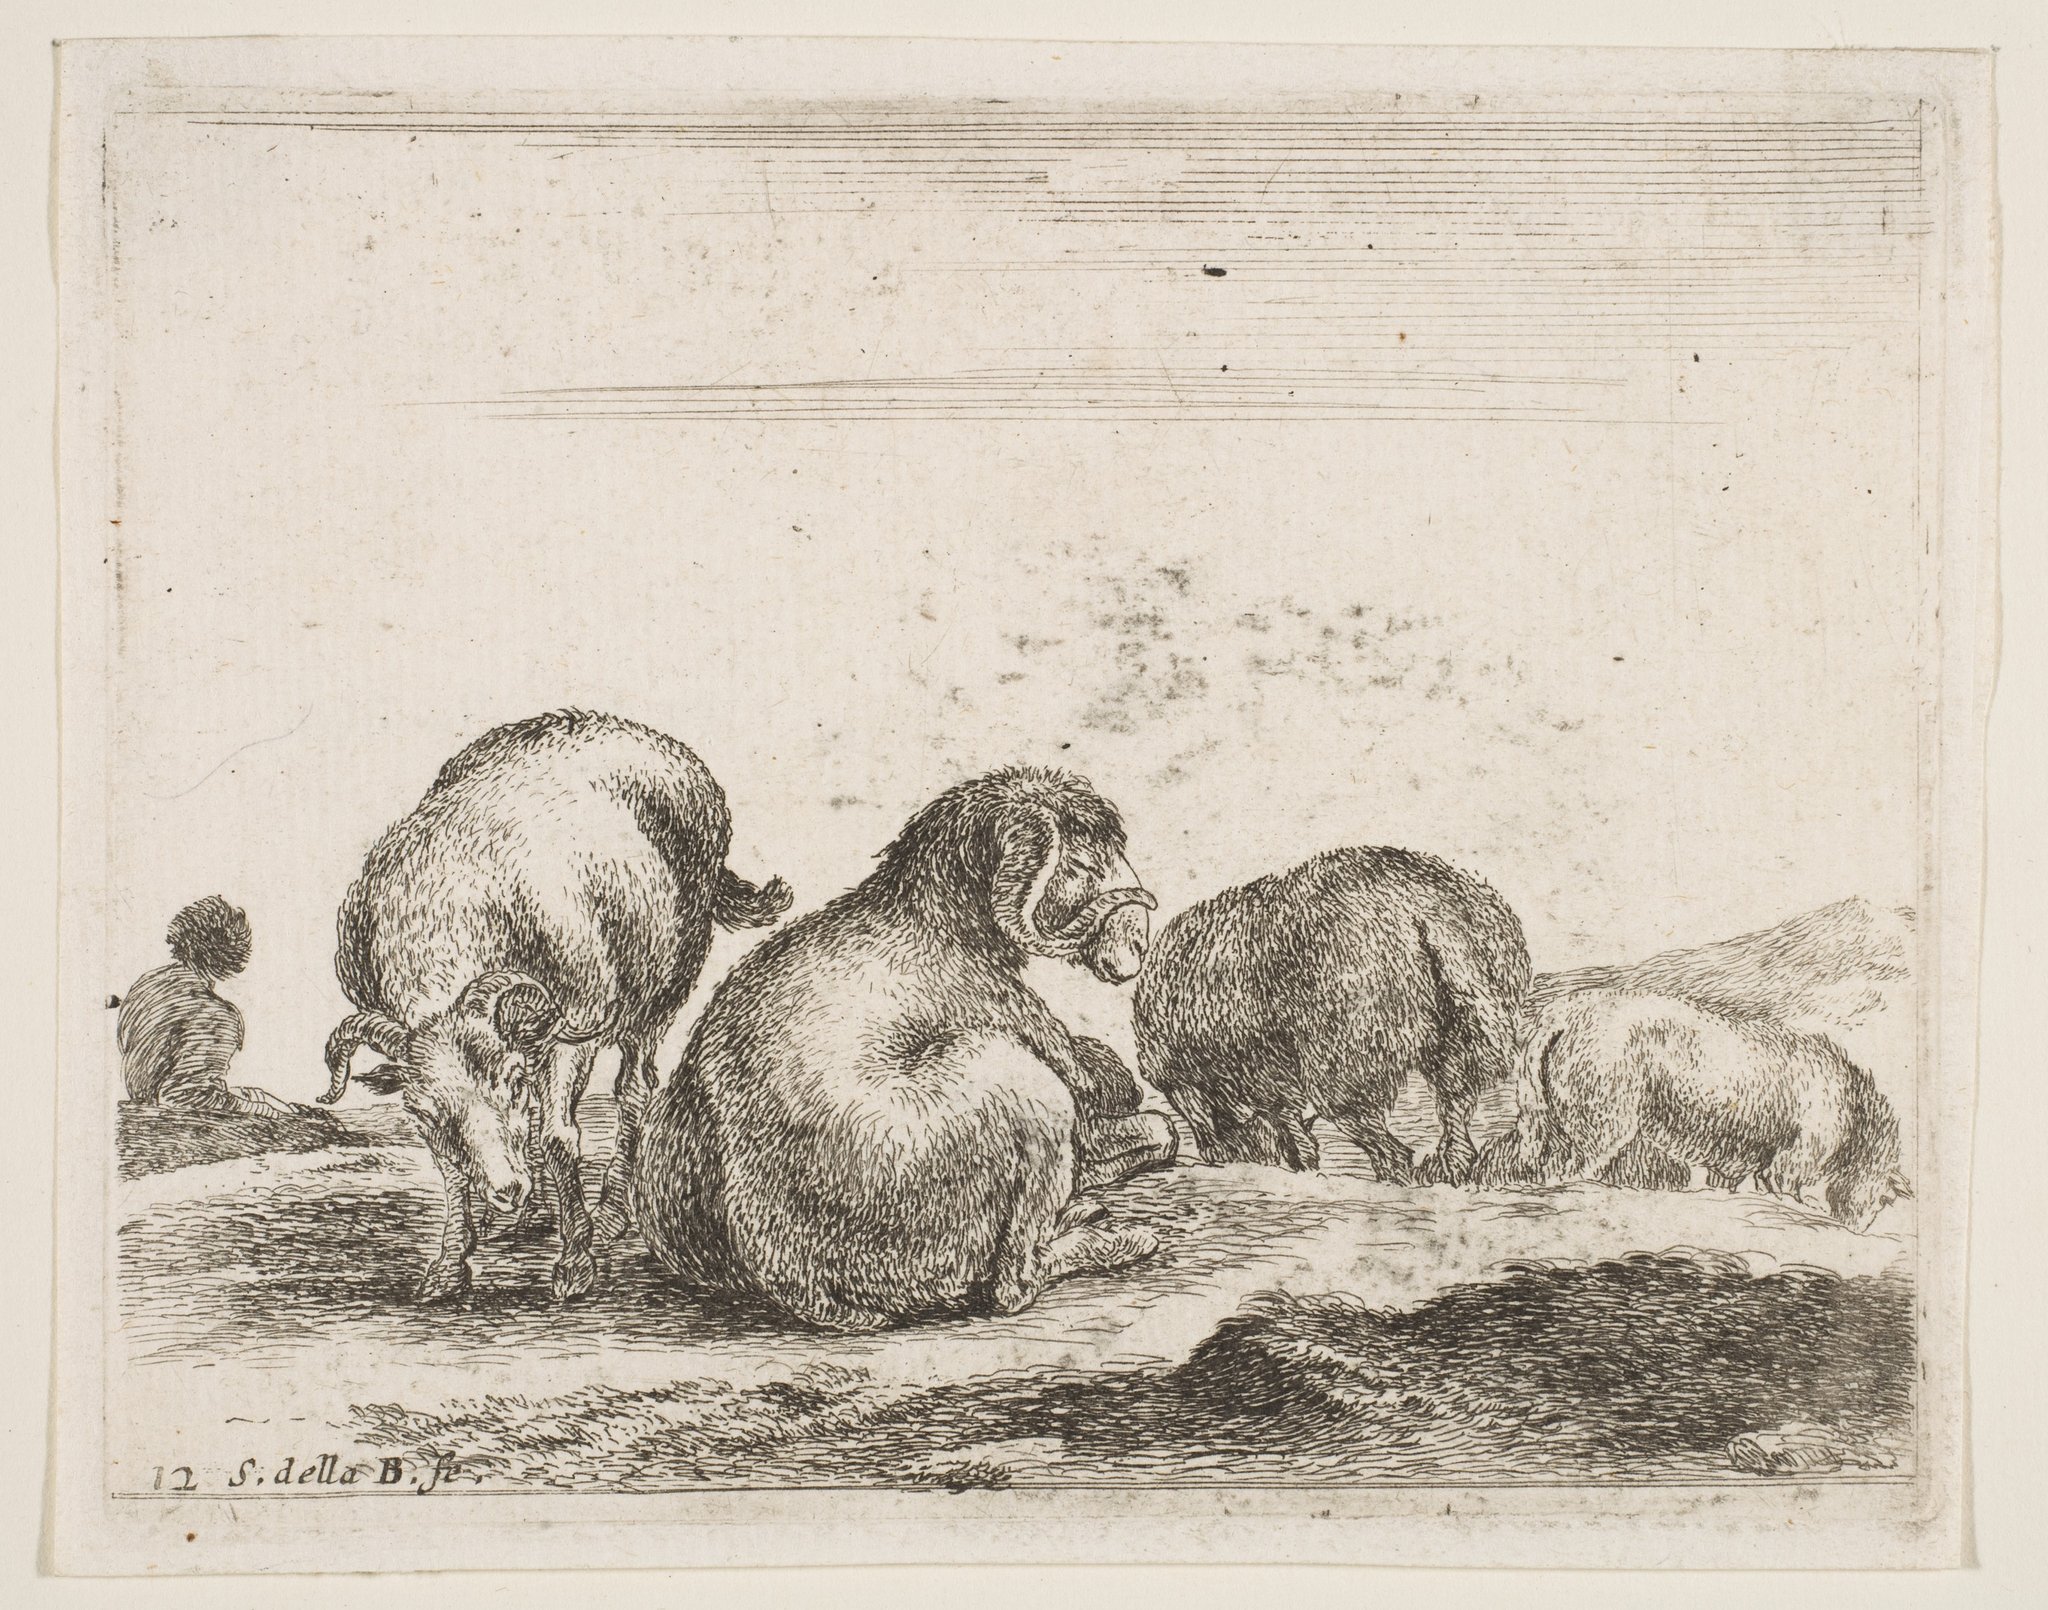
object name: print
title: Sheep and ram in a pasture, plate 12 from "Various Animals" (Diversi Animali)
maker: stefano della bella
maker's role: artist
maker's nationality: italian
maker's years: 1610-1664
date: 1641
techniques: etching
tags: rams,sheep